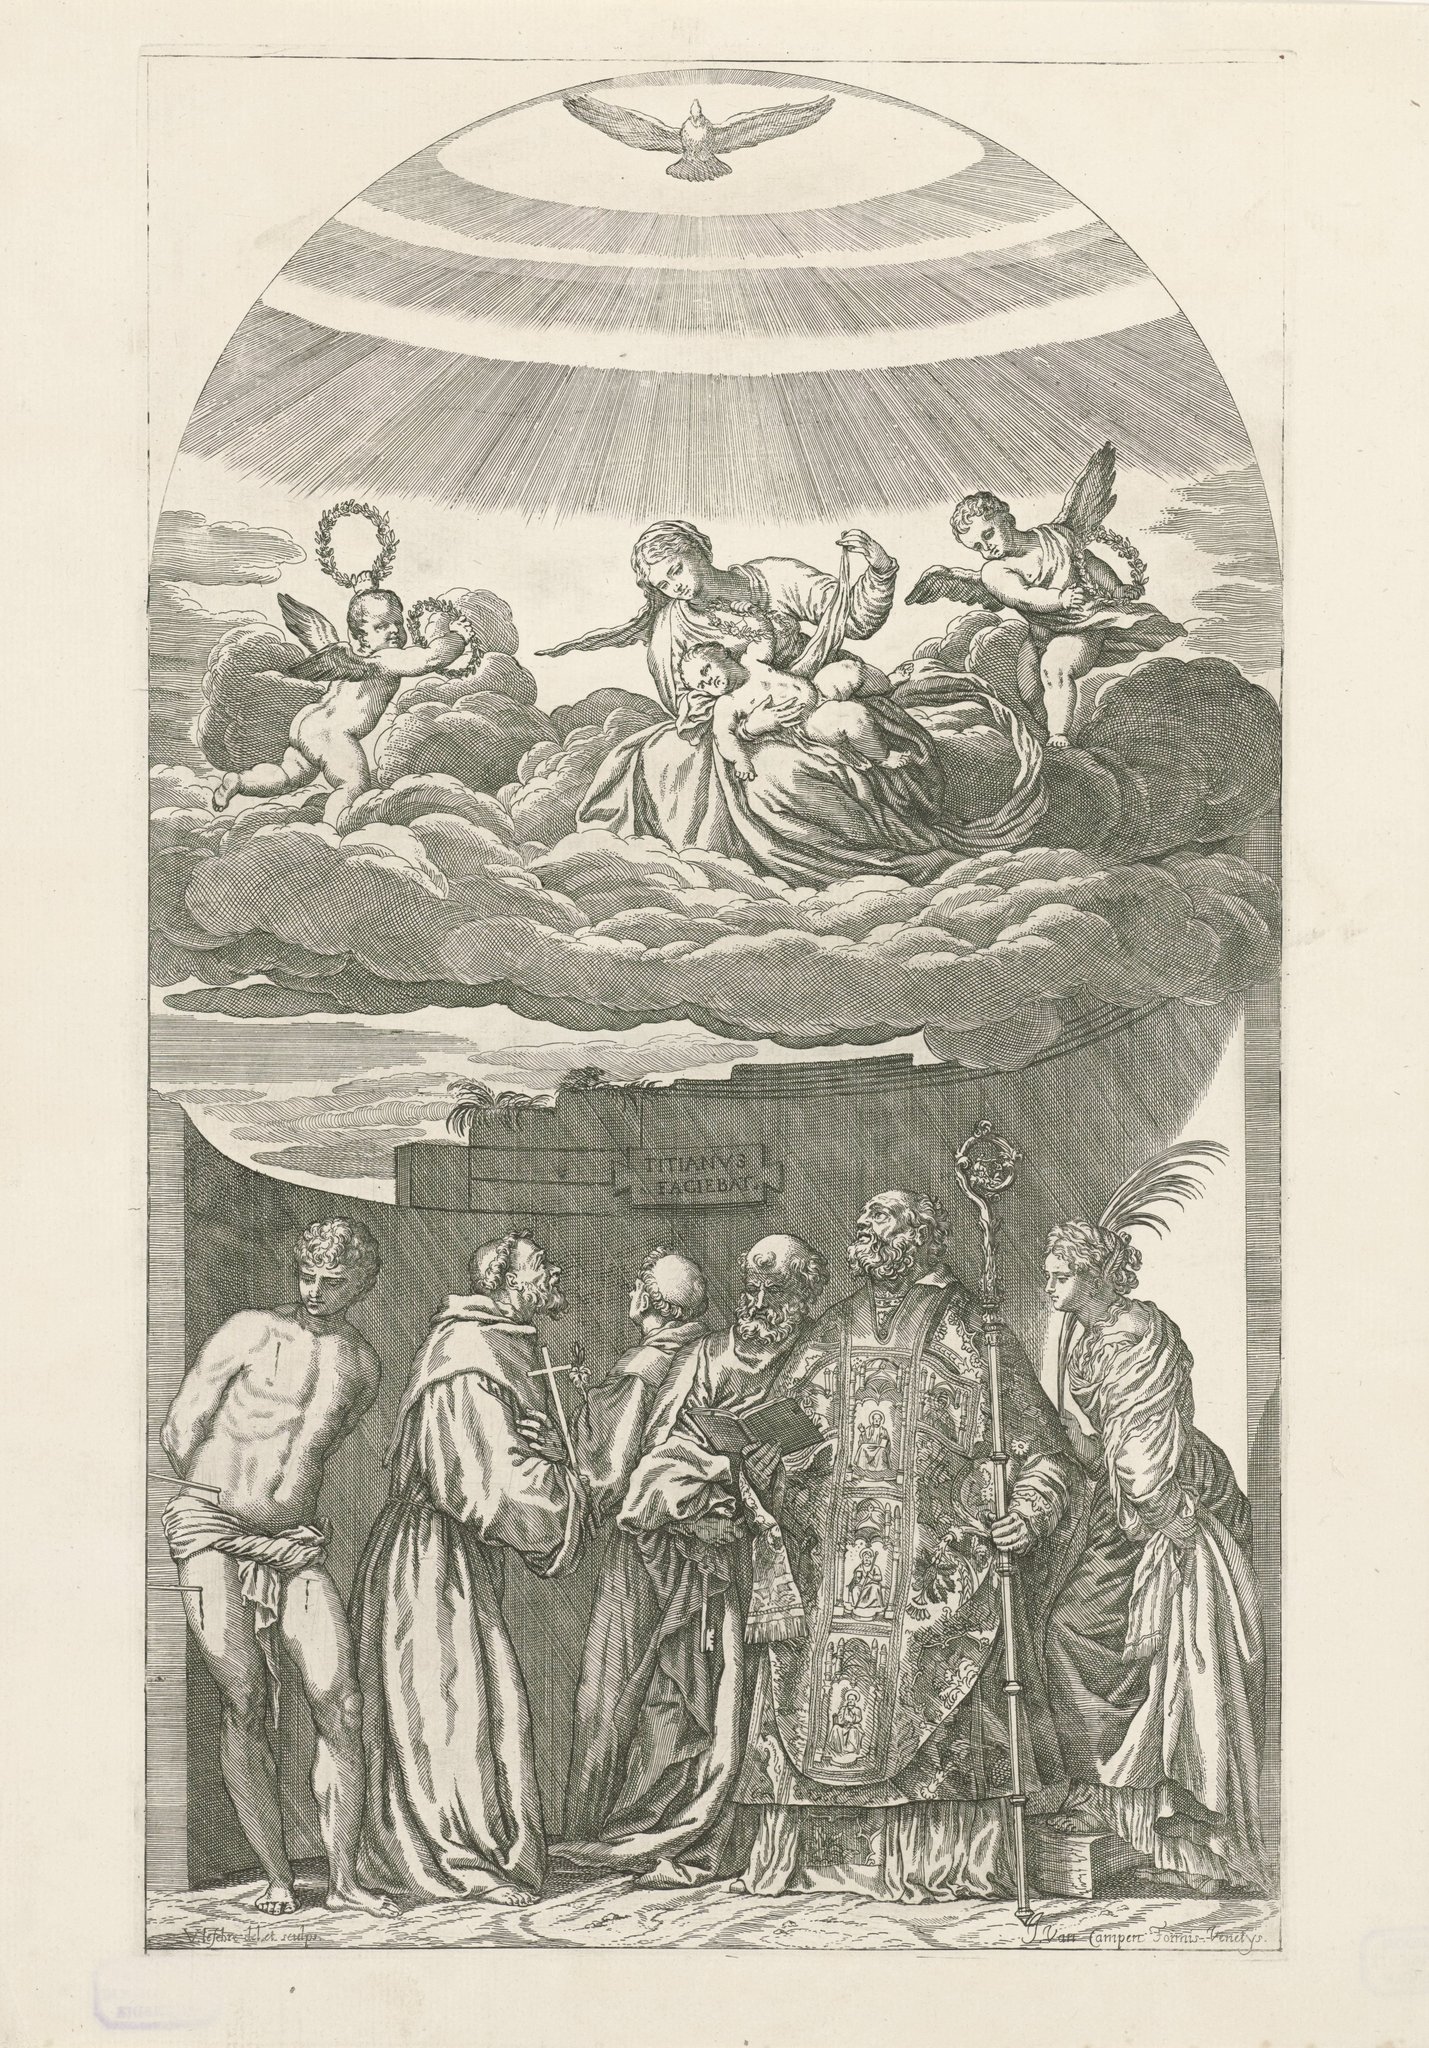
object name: print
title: Maria met Christuskind en heiligen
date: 1682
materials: paper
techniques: etching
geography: venice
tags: the virgin martyr catherine of alexandria; possible attributes: book, crown, emperor maxentius, palm-branch, ring, sword, wheel, madonna: i.e. mary with the christ-child, the bishop nicholas of myra (or bari); possible attributes: anchor, boat, three golden balls (on a book), three purses, three children in a tub, three maidens, the martyr sebastian; possible attributes: arrow(s), bow, tree-trunk, founder of the order of friars minor (franciscans), francis(cus) of assisi; possible attributes: book, crucifix, lily, skull, stigmata, the apostle peter, first bishop of rome; possible attributes: book, cock, (upturned) cross, (triple) crozier, fish, key, scroll, ship, tiara, the franciscan monk antony of padua; possible attributes: ass, book, crucifix, flowered cross, flaming heart, infant christ (on book), lily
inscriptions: collector's mark: Lugt 11, collector's mark: Lugt 11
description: Maria zit met het Christuskind op een wolkendek. In de lucht hierboven is de Heilige Geest in de gedaante van een duif verschenen, links en rechts engelen met lauwerkransen. Op de grond onder de wolken staan de heiligen Sebastiaan, Franciscus van Assisi, Antonius van Padua, Petrus, Nicolaas en Catharina. De prent maakt deel uit van een 53-delige serie prenten naar schilderijen van Titiaan en Veronese.